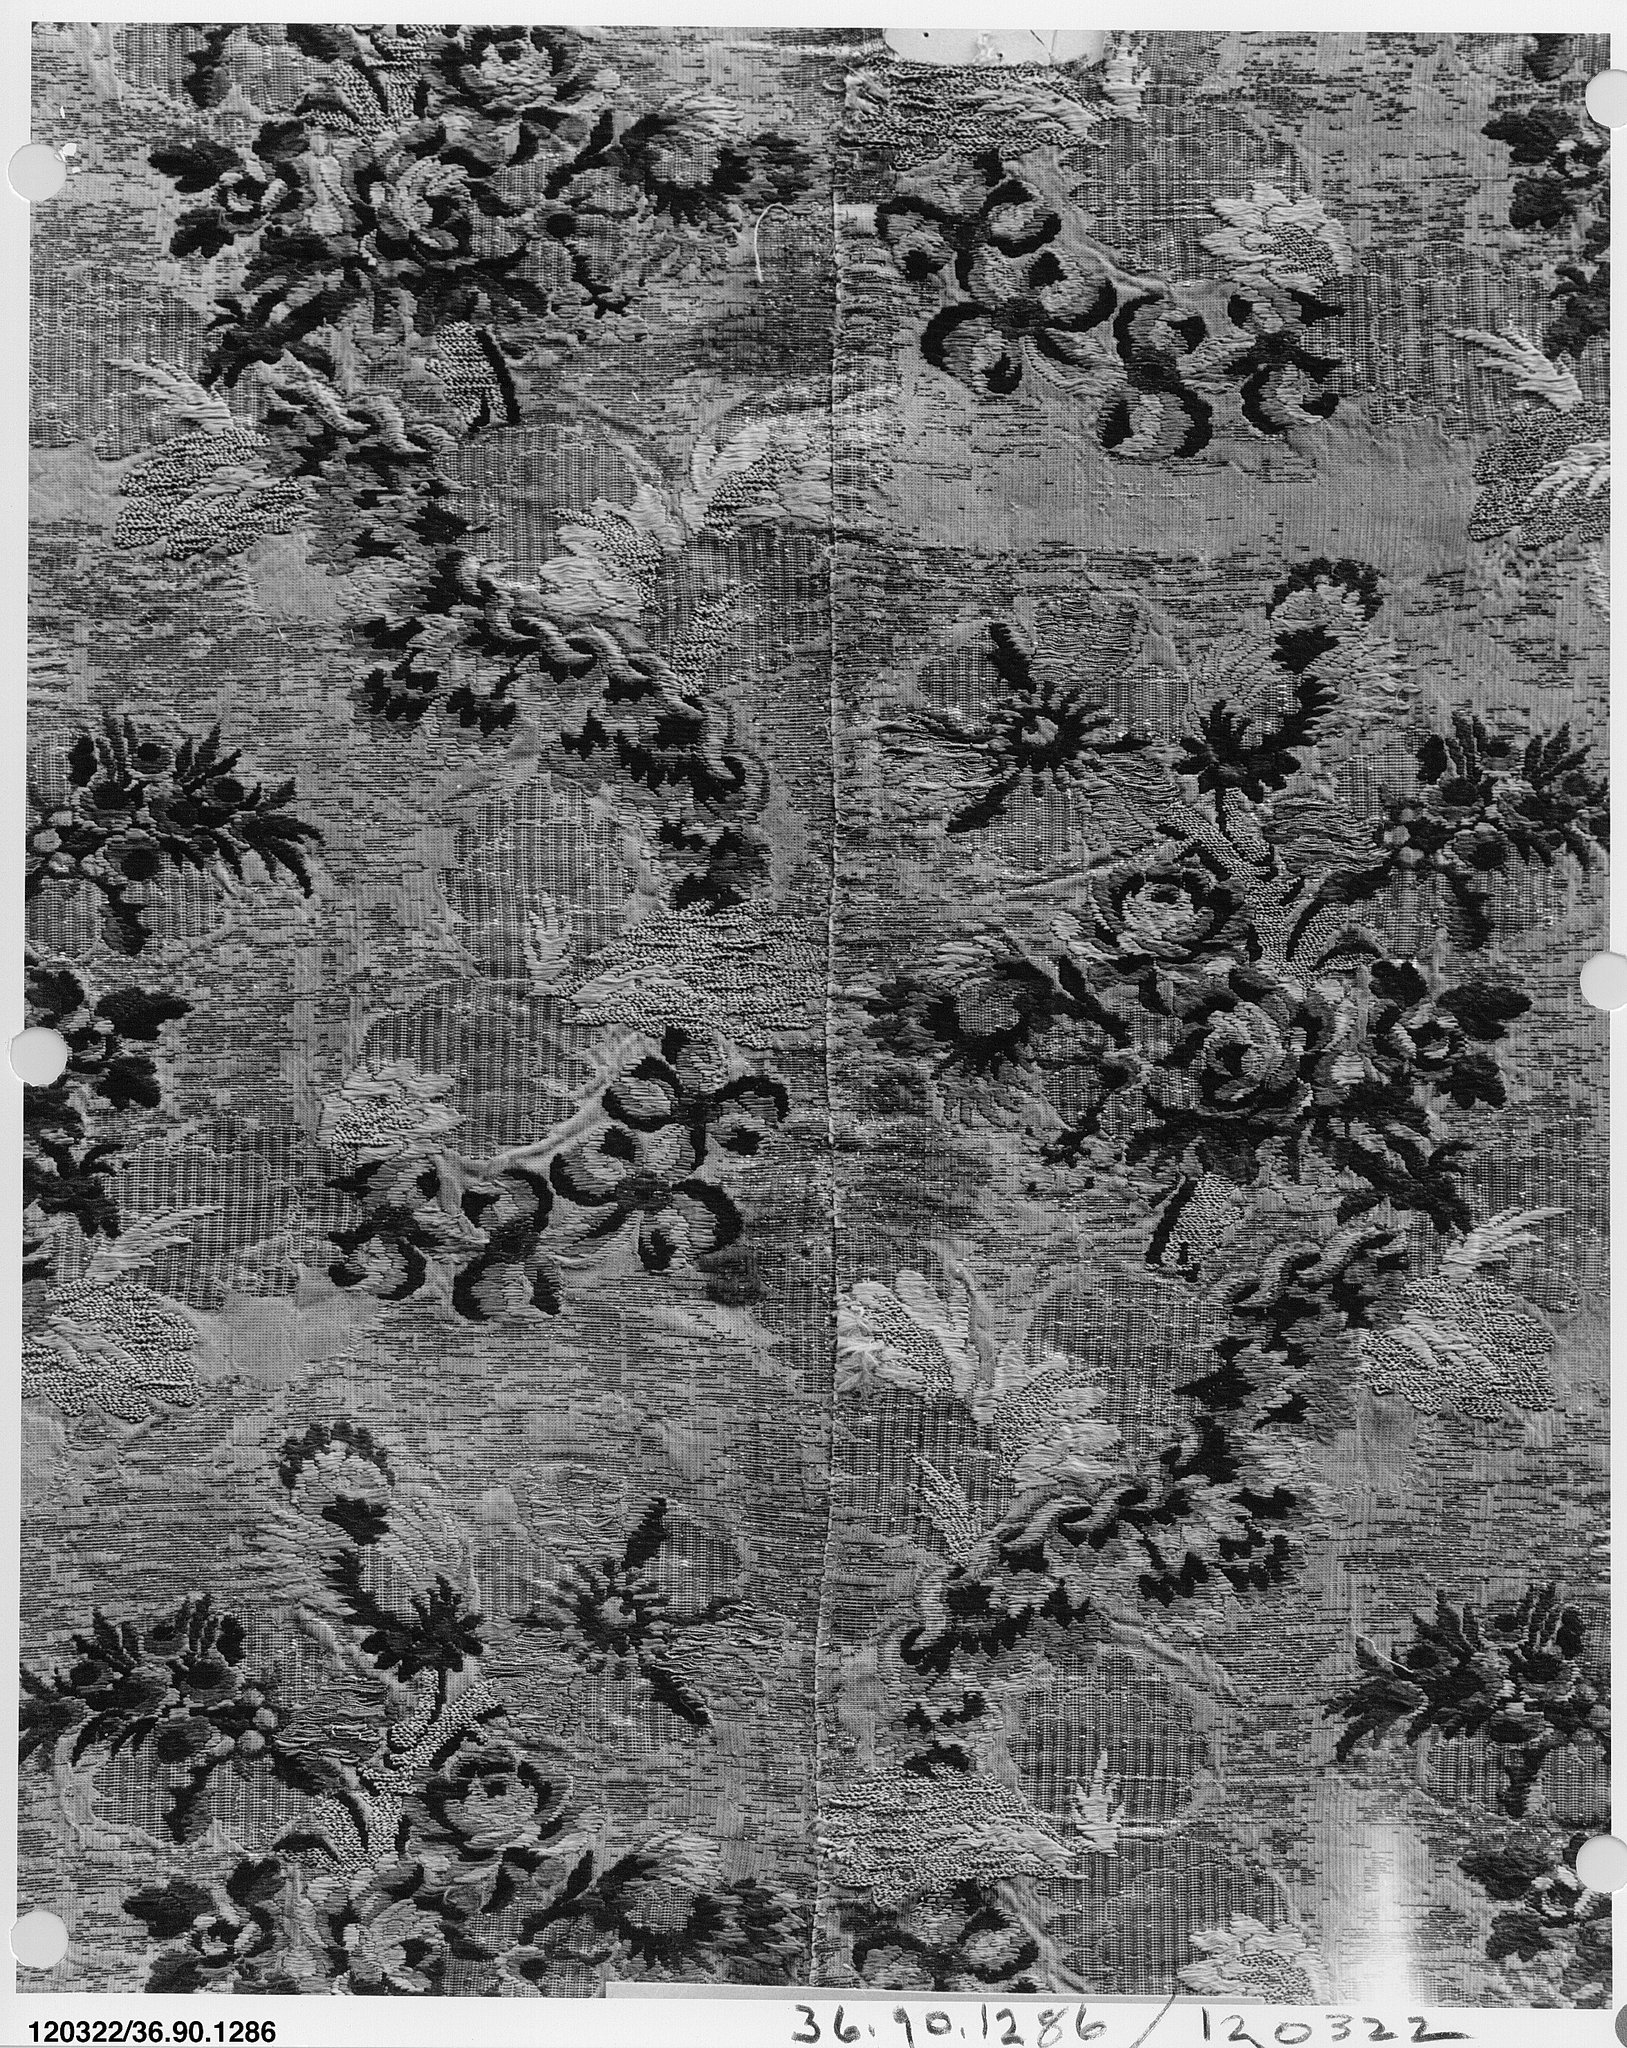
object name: piece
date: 1750-1760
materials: metal thread, silk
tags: flowers,leaves